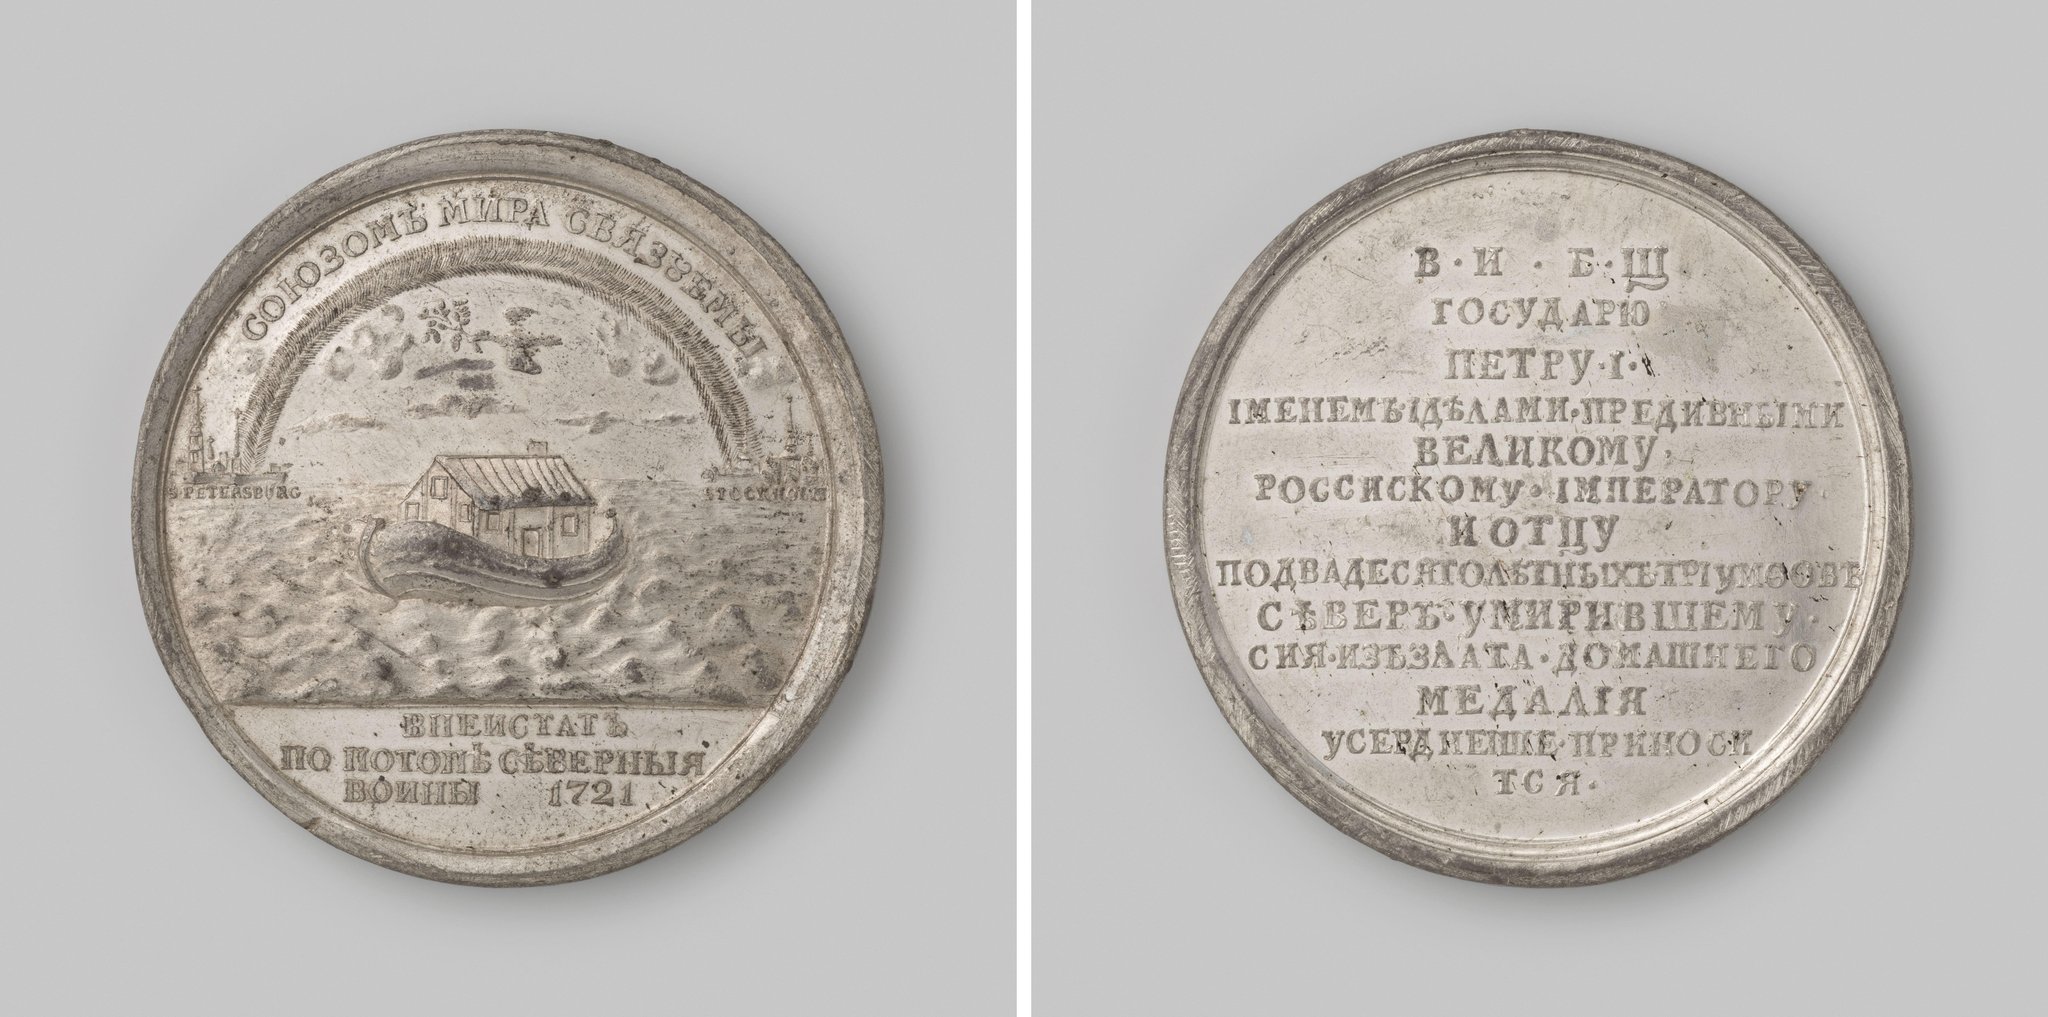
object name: history medal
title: Vrede van Neustadt tussen Rusland en Zweden 1721 (Russische tekst)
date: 1721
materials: tin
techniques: striking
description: Tinnen penning, op de voorzijde een ark op zee waarboven een duif met olijftak, op de achtergrond Petersburg en Stockholm door een boog verbonden, met Russisch omschrift en afsnedetekst, op de keerzijde twaalf regels Russische tekst.